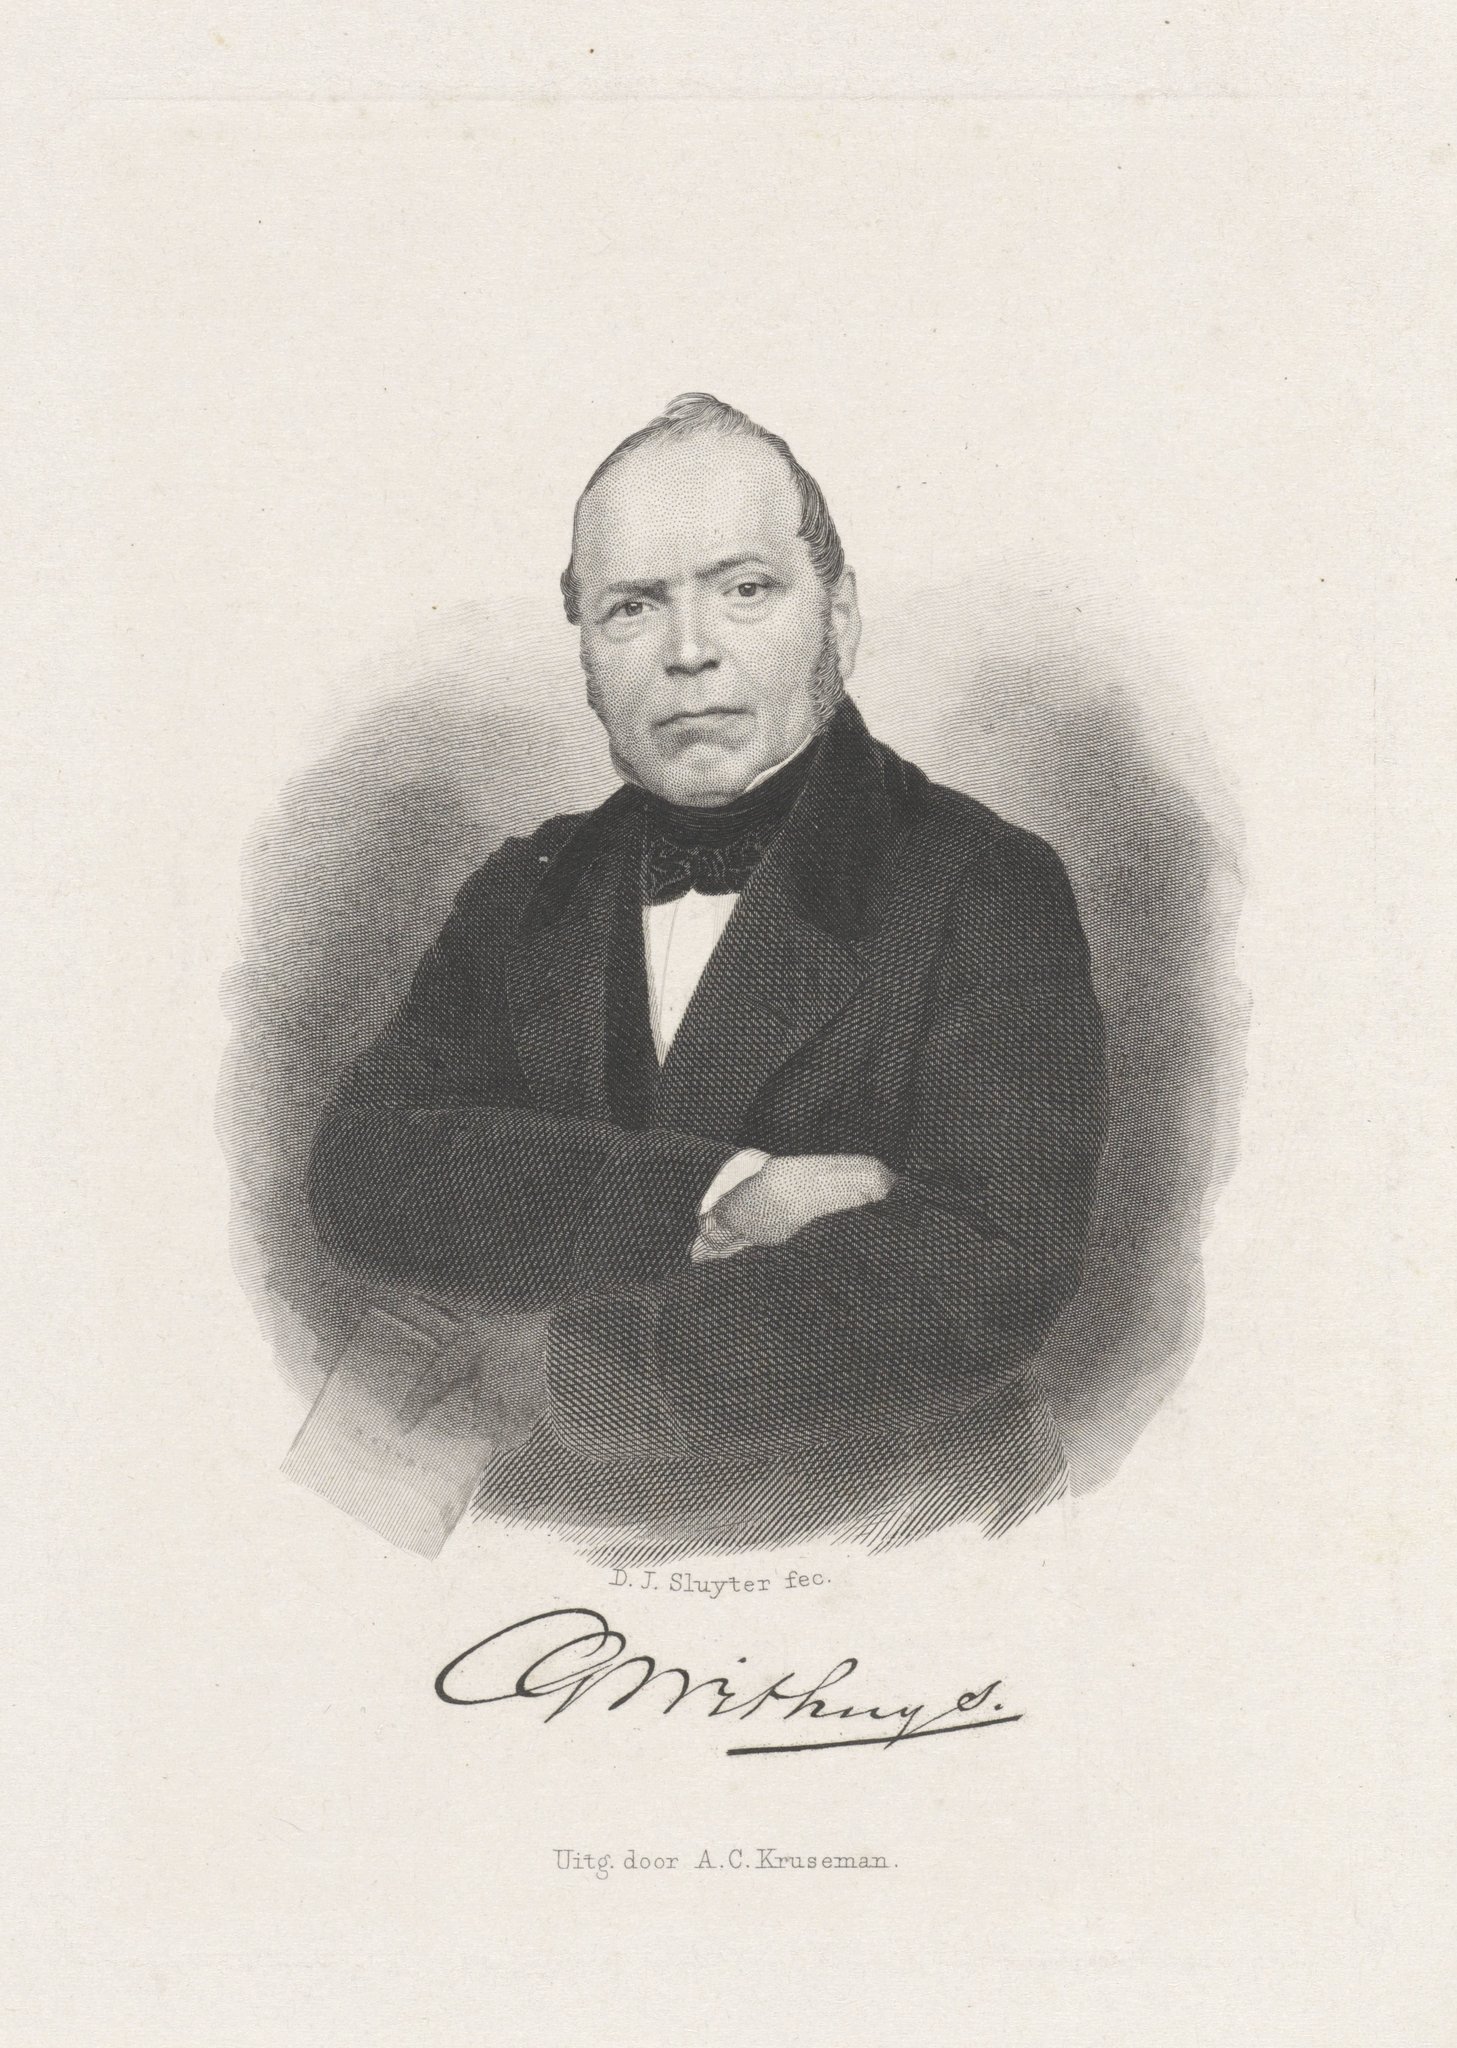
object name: print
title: Portret van de dichter Carel Godfried Withuys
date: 1842-1873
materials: paper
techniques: aquatint, etching, engraving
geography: amsterdam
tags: the hague, carel godfried withuys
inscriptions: collector's mark: Lugt 2228